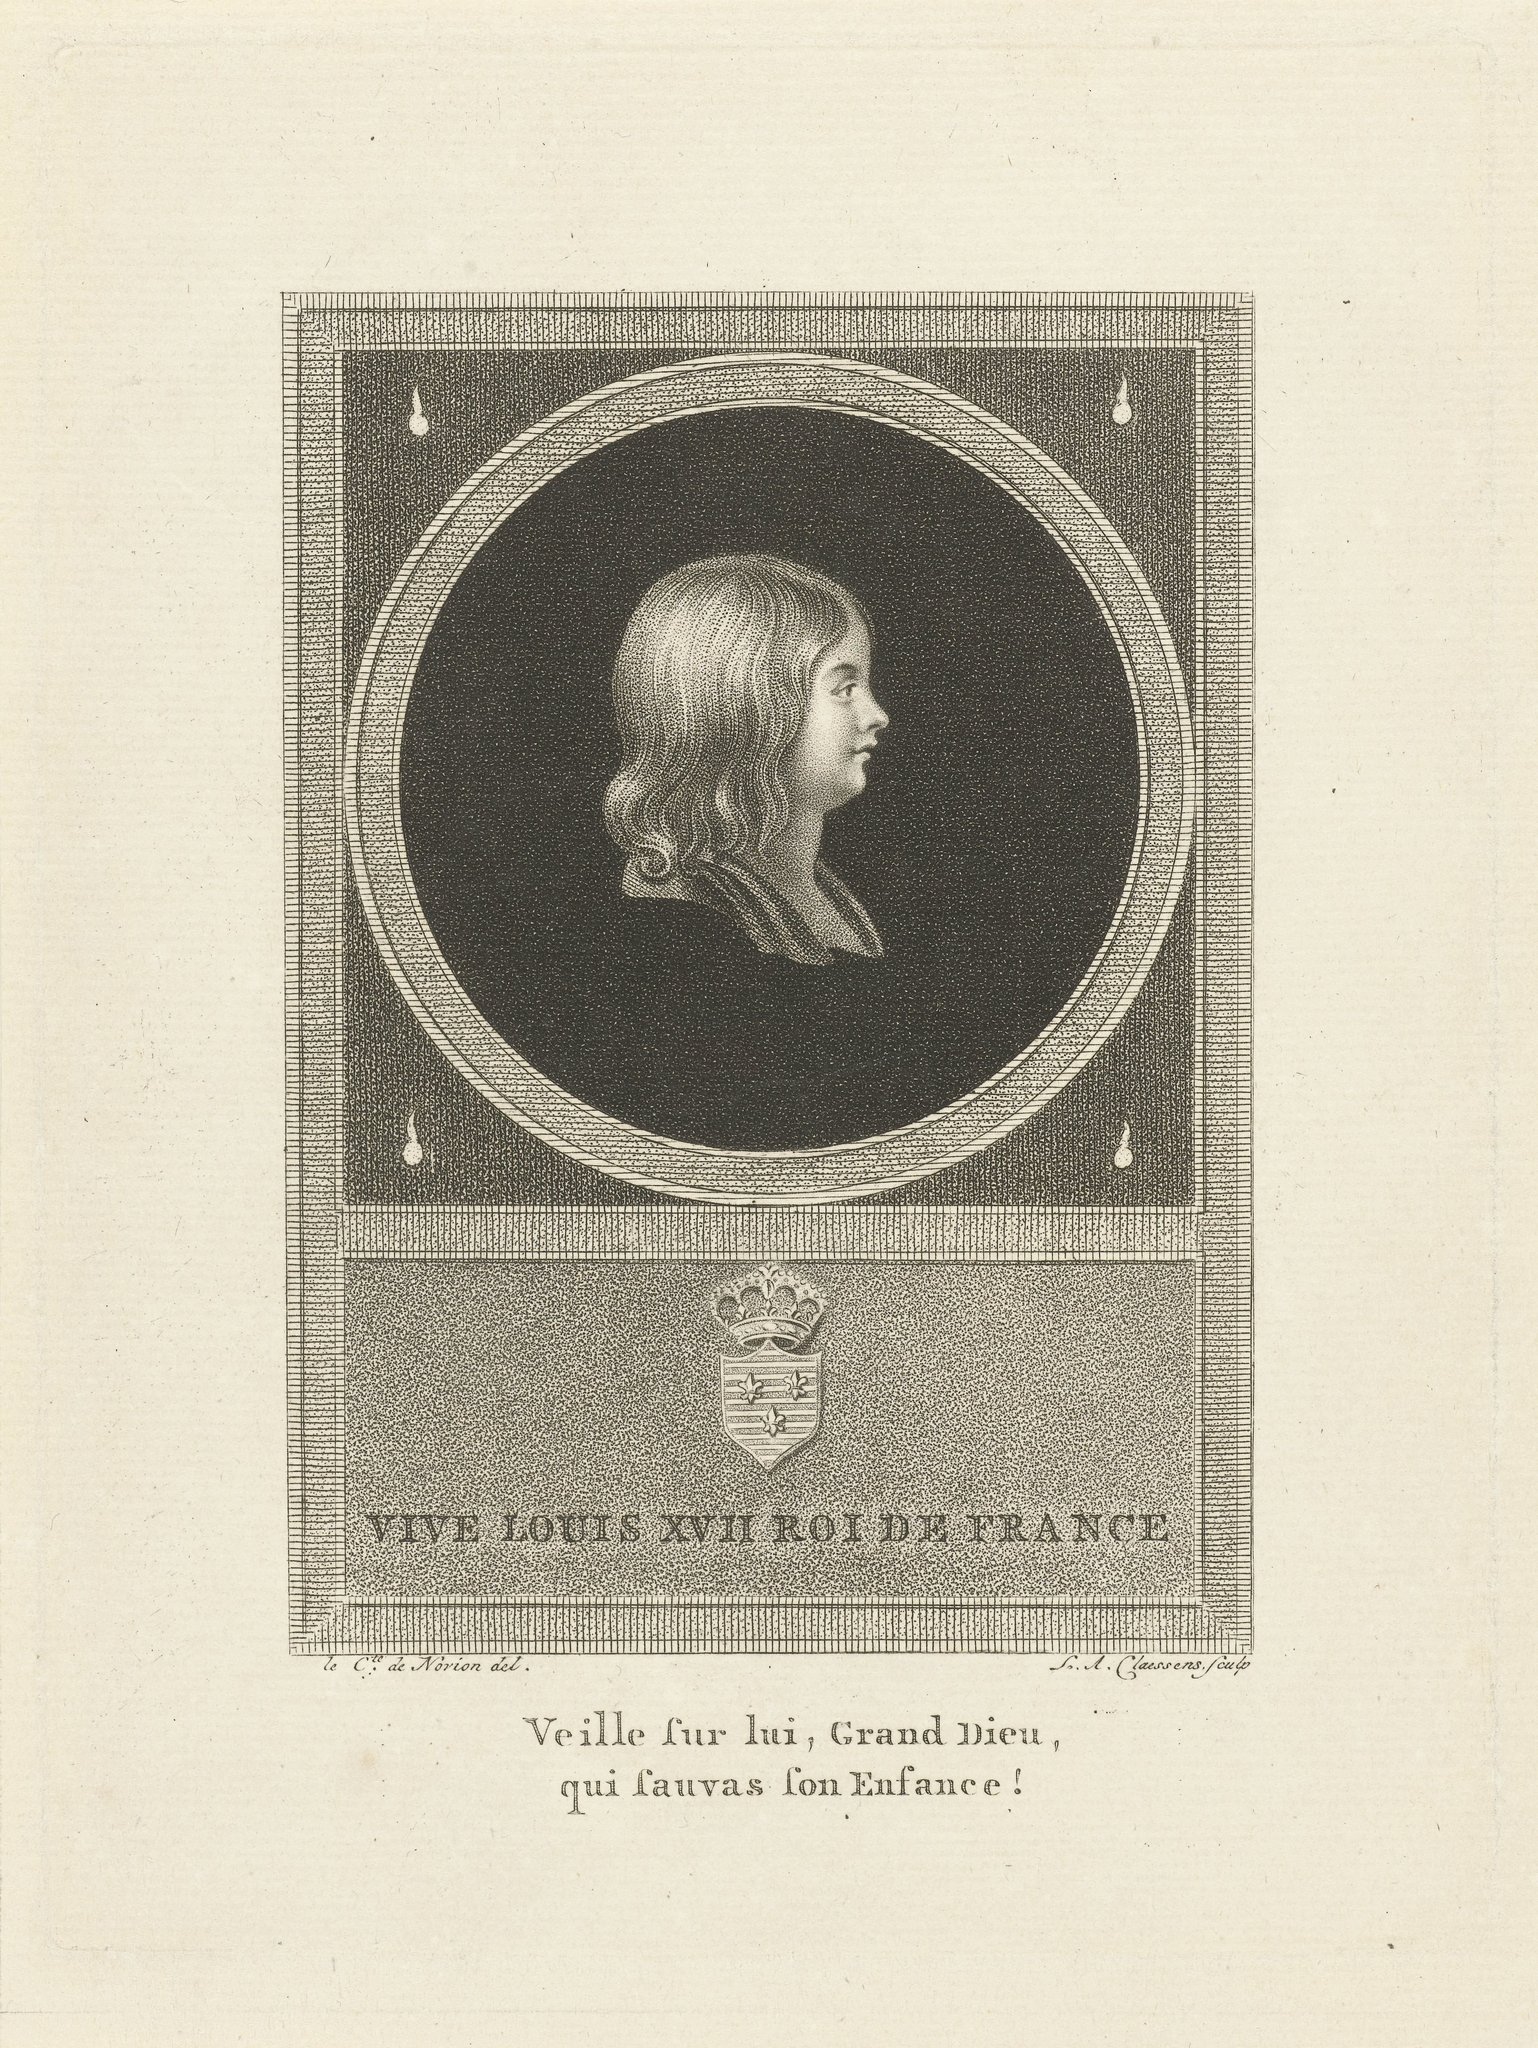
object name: print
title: Memorieprent met portret van Lodewijk XVII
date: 1795-1808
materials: paper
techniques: engraving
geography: amsterdam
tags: lodewijk xvii (koning van frankrijk)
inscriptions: collector's mark: Lugt 2228